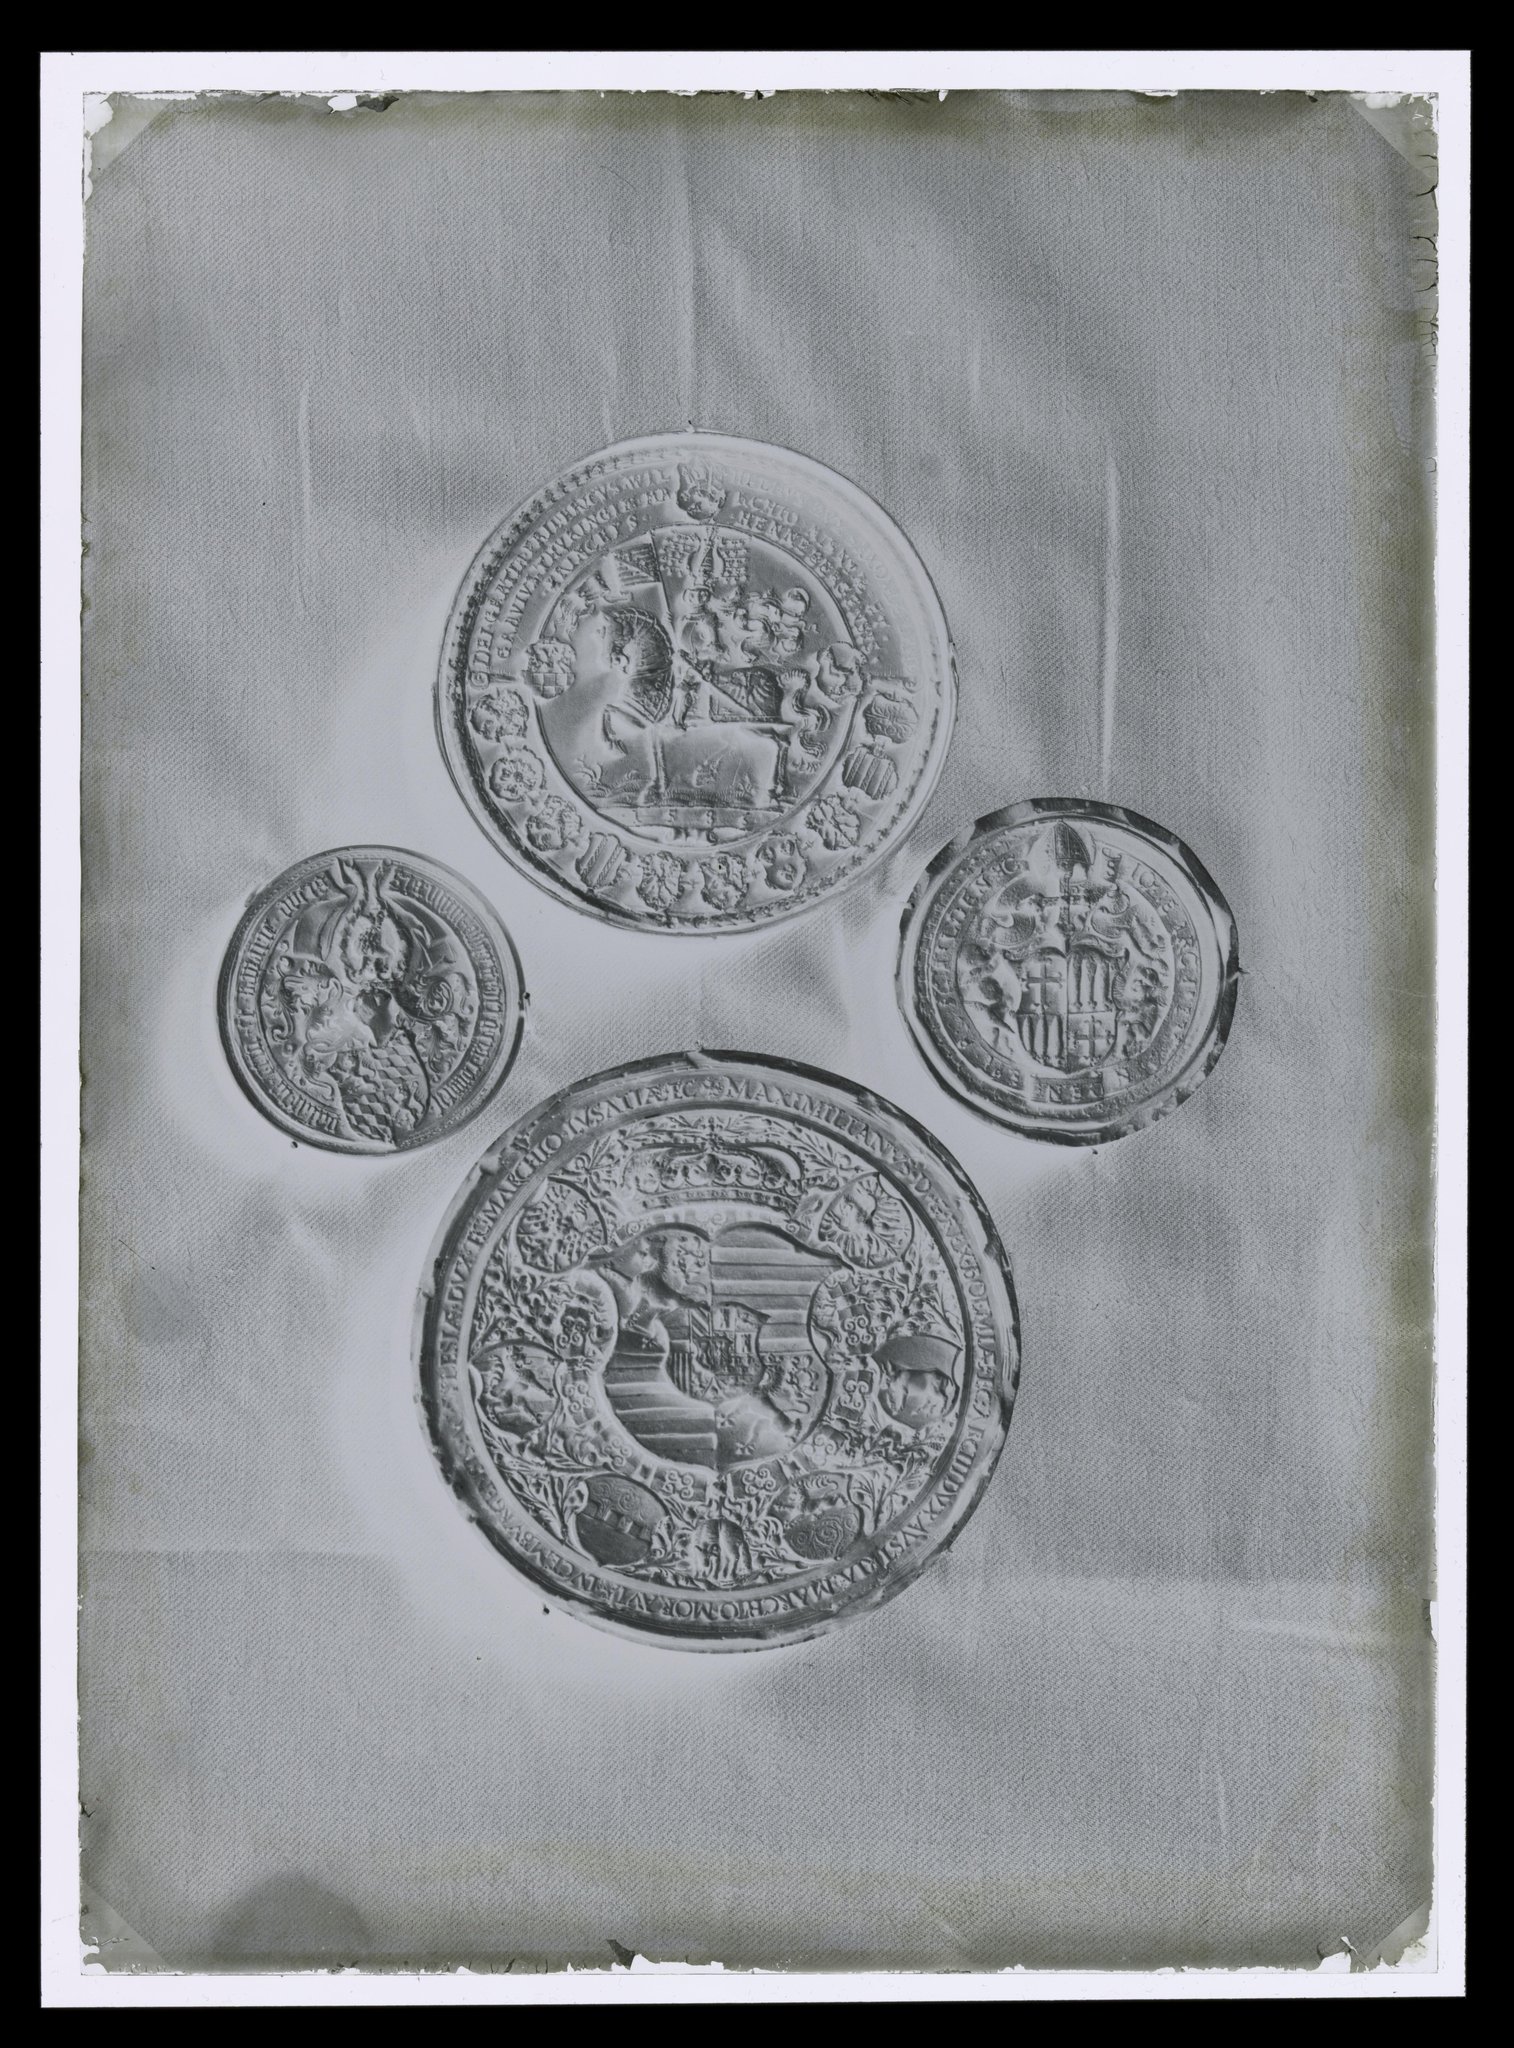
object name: glasnegatief, glasplaatnegatief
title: Vier penningen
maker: laurens lodewijk kleijn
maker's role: draughtsman, painter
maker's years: 1826-1909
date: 1865-1900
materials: glass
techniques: collodion process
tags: armorial bearing, heraldry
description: Onderdeel van een groep glasnegatieven uit de nalatenschap van de schilder Laurens Lodewijk Kleijn, met stillevens, portretten, zelfportretten en kunstreproducties.